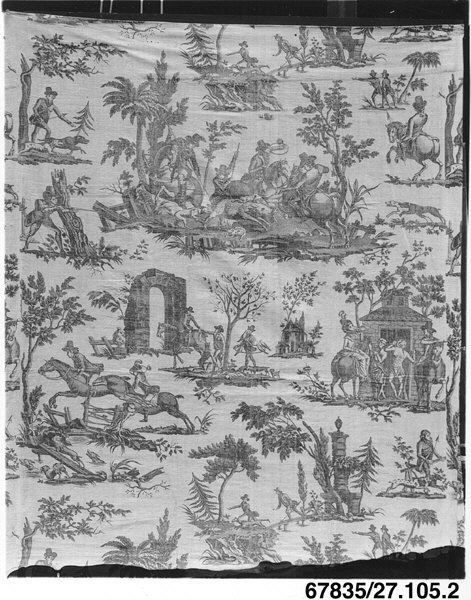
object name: furnishing textile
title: "La Chasse au Sanglier"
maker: lafosse, lionnet et médard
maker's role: manufactory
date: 1785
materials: cotton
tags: men,horses,trees